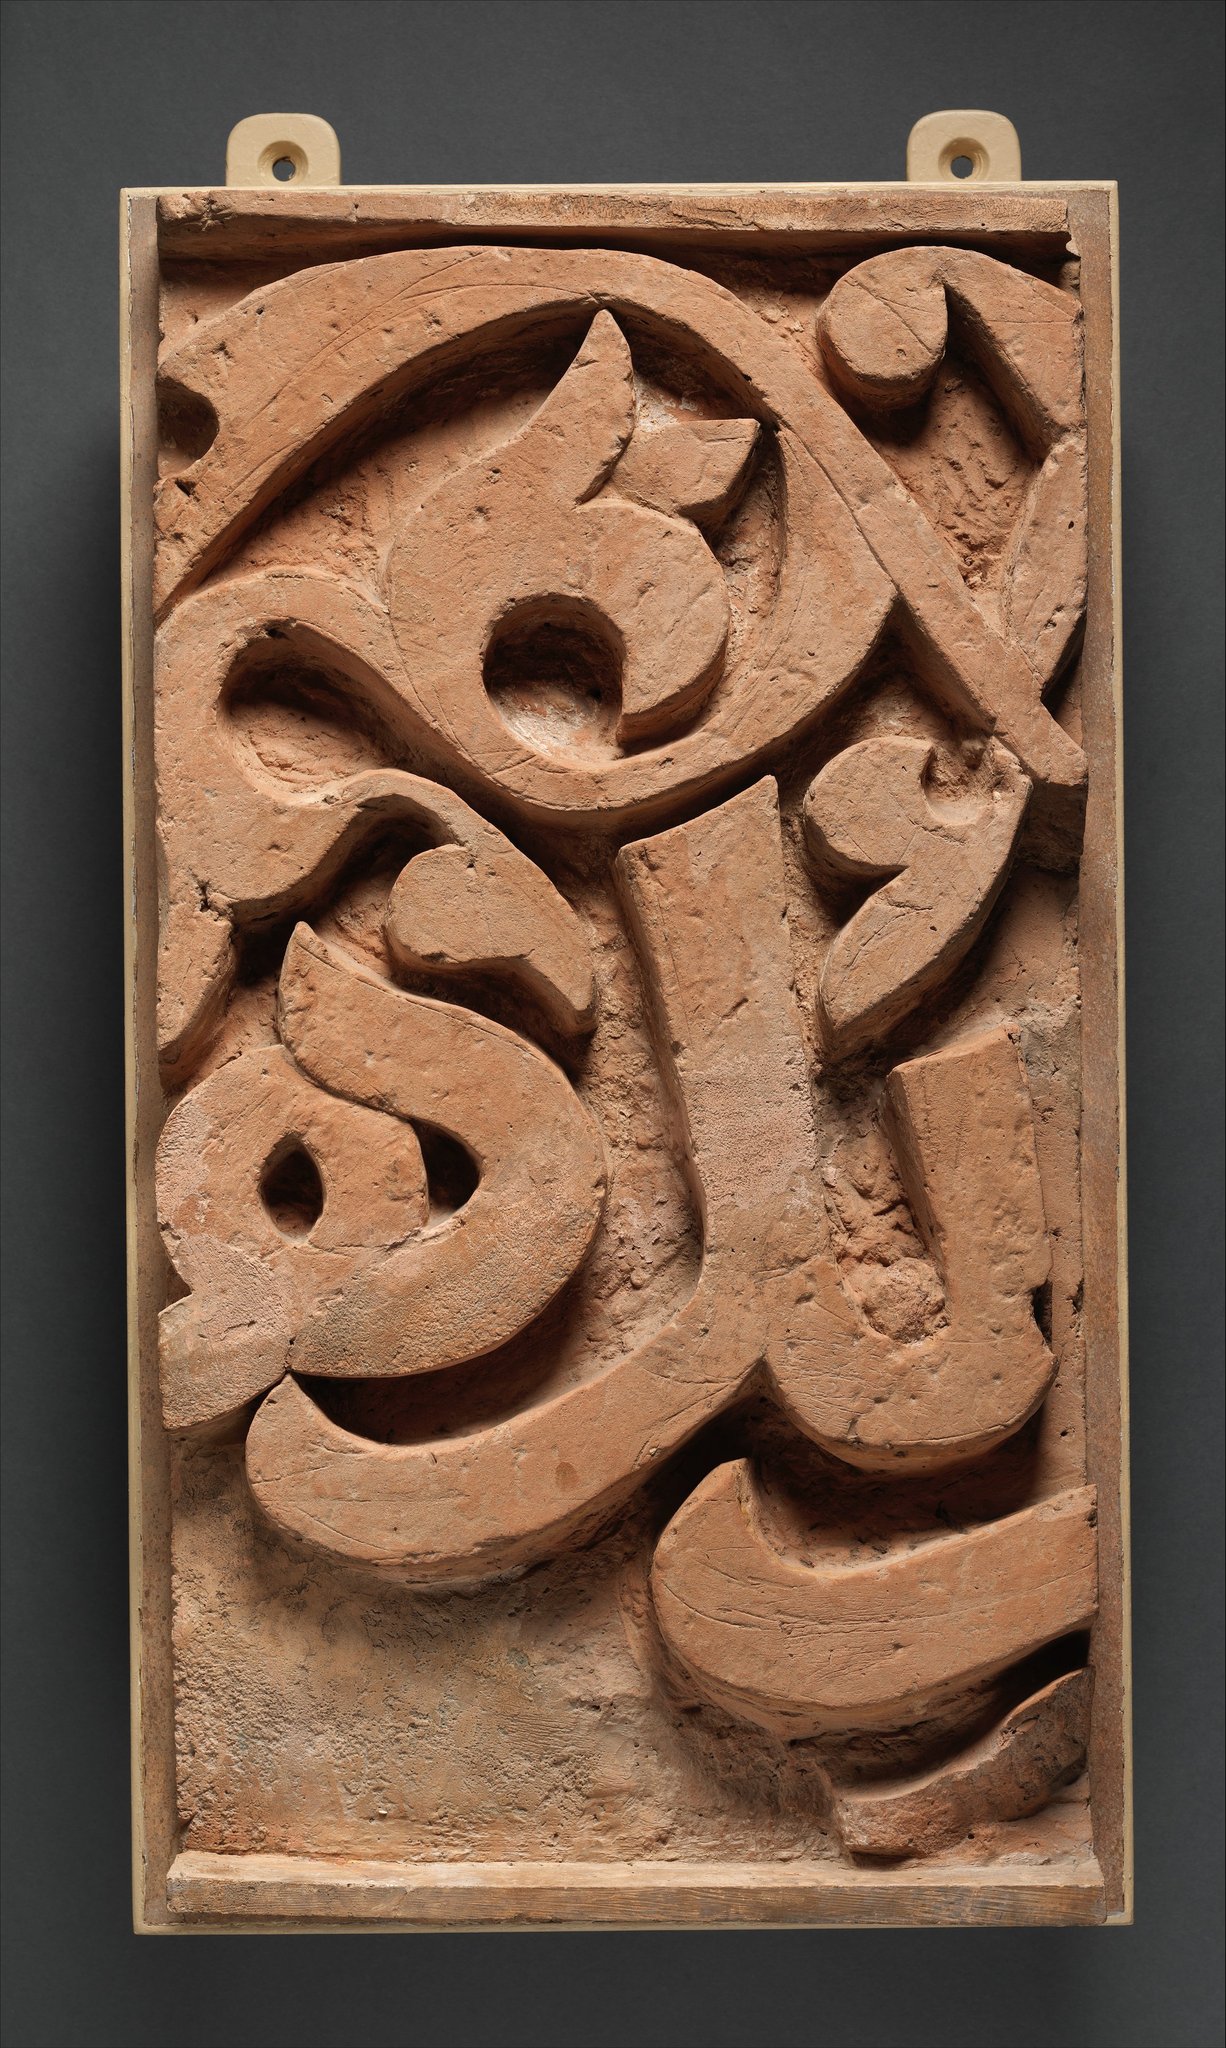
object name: frieze fragment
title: Panel from a Mosque Frieze Bearing the Name of a Sultan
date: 1001-1100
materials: terracotta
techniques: carving, painting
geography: iran